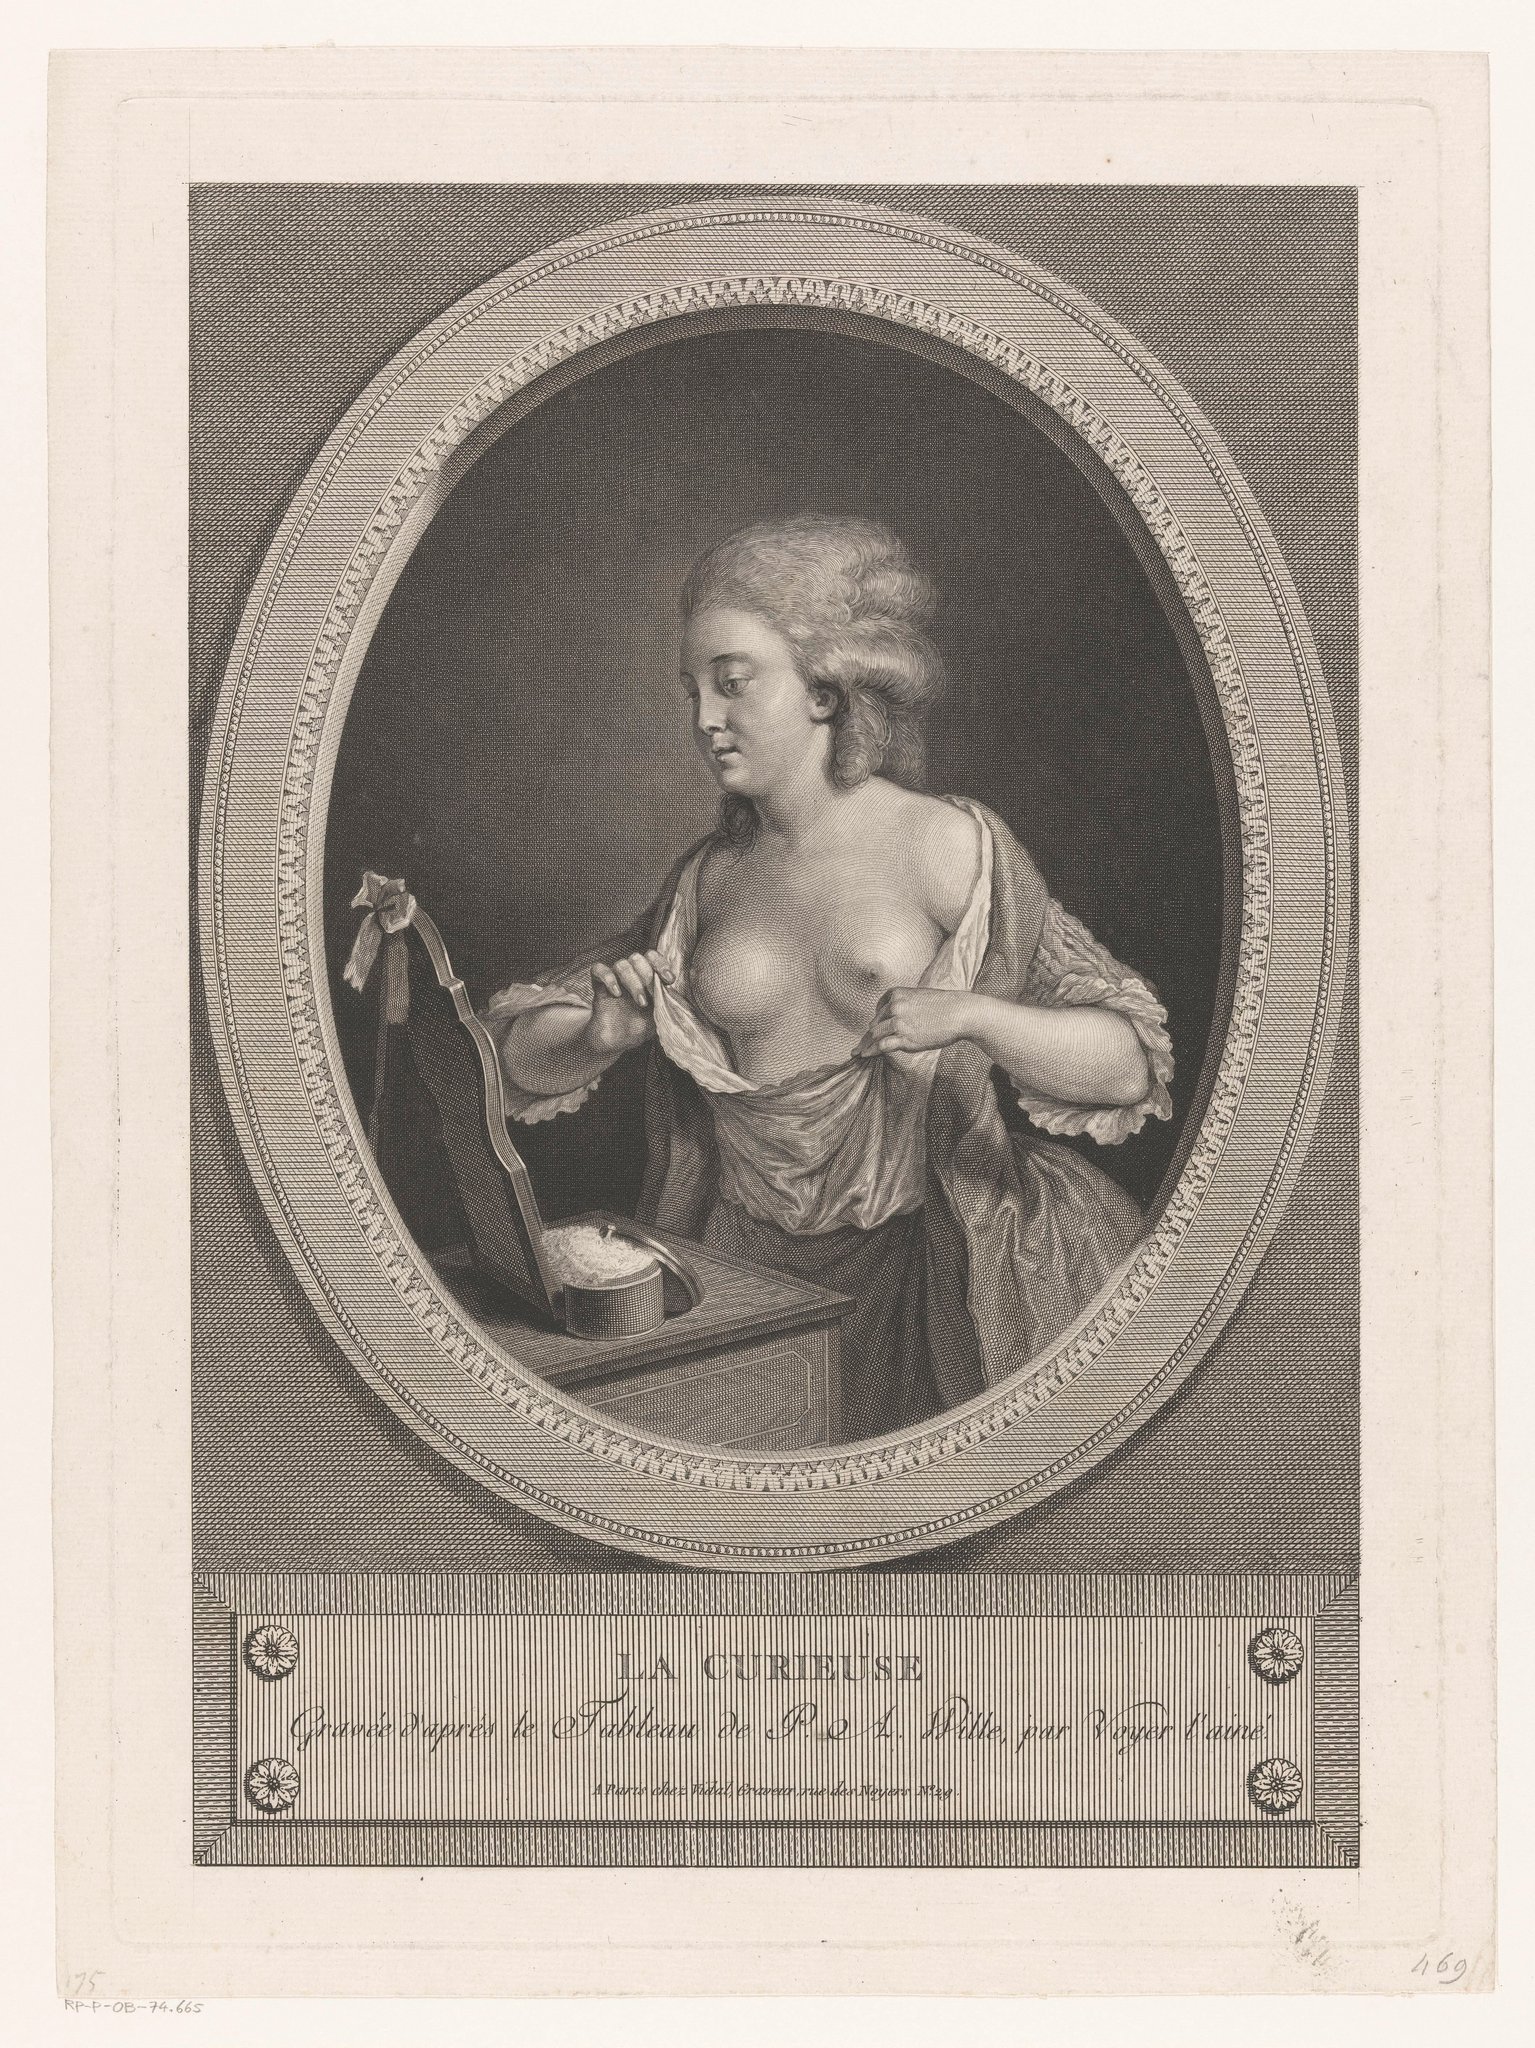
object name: print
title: La Curieuse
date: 1758-1801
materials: paper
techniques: engraving, etching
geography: france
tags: breasts, woman (showing herself) undressed, quasi-nude, mirror - aa - (for) women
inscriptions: collector's mark: Lugt 2228